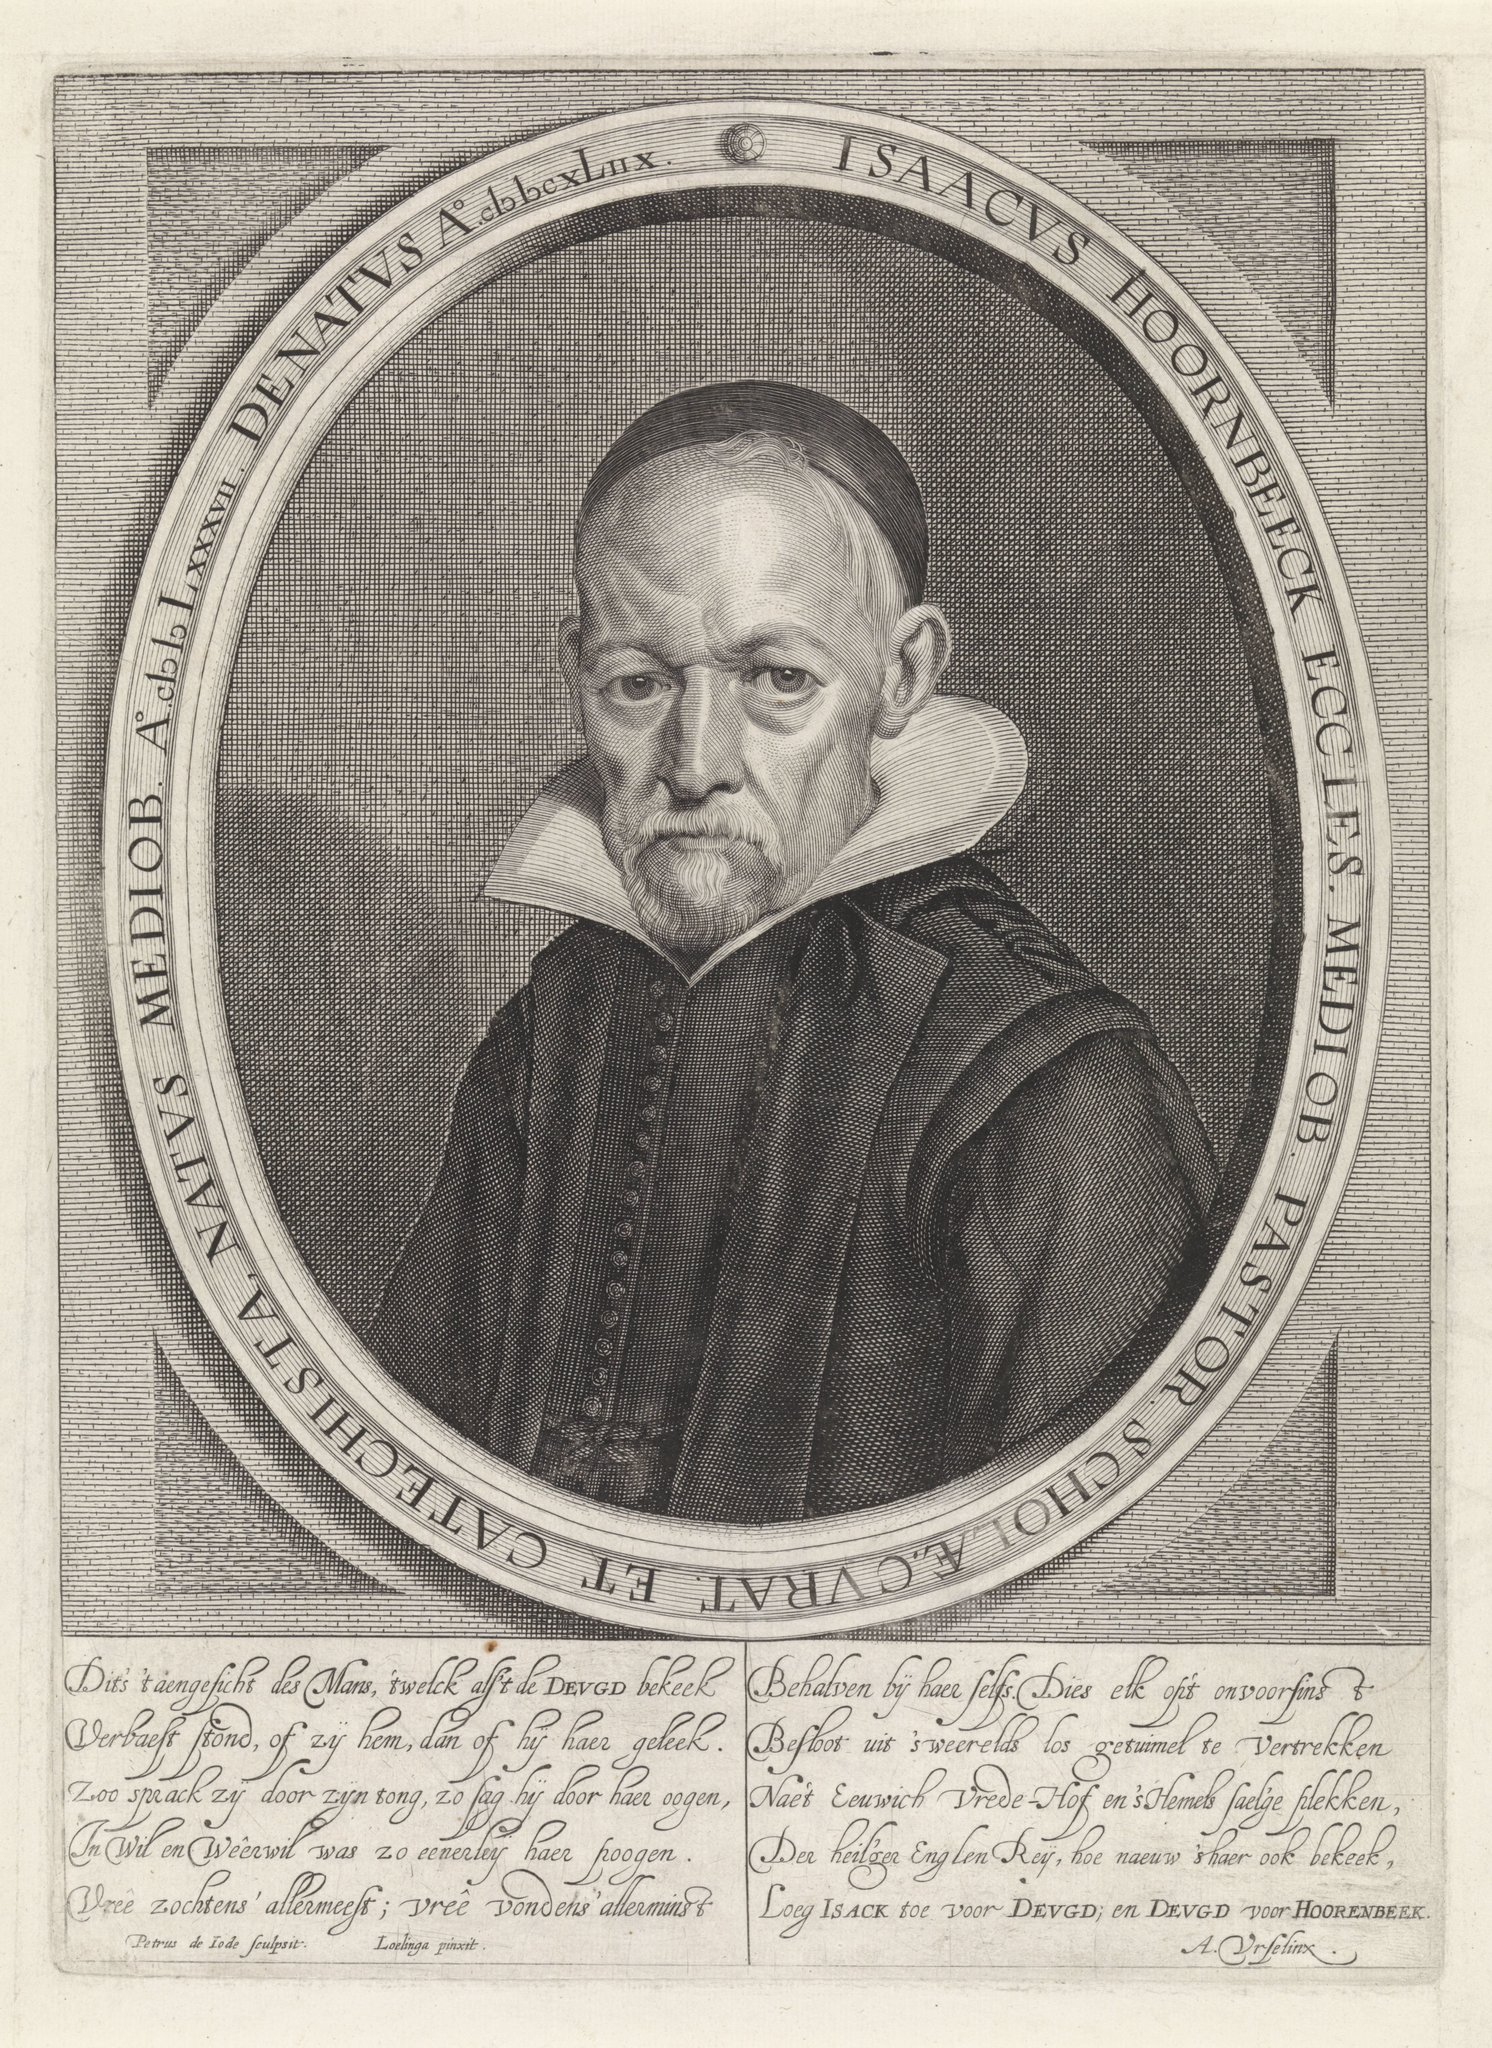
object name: print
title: Portret van Isaac Hoornbeeck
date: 1628-1670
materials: paper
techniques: engraving, etching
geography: antwerp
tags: predikant, isaac hoornbeeck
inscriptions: collector's mark: Lugt 240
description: Busteportret van de predikant Isaac Hoornbeeck, met kalot. Het portret is gevat in een ovale omlijsting met een randschrift in het Latijn. In de marge, in twee kolommen, een tienregelig gedicht in het Nederlands.